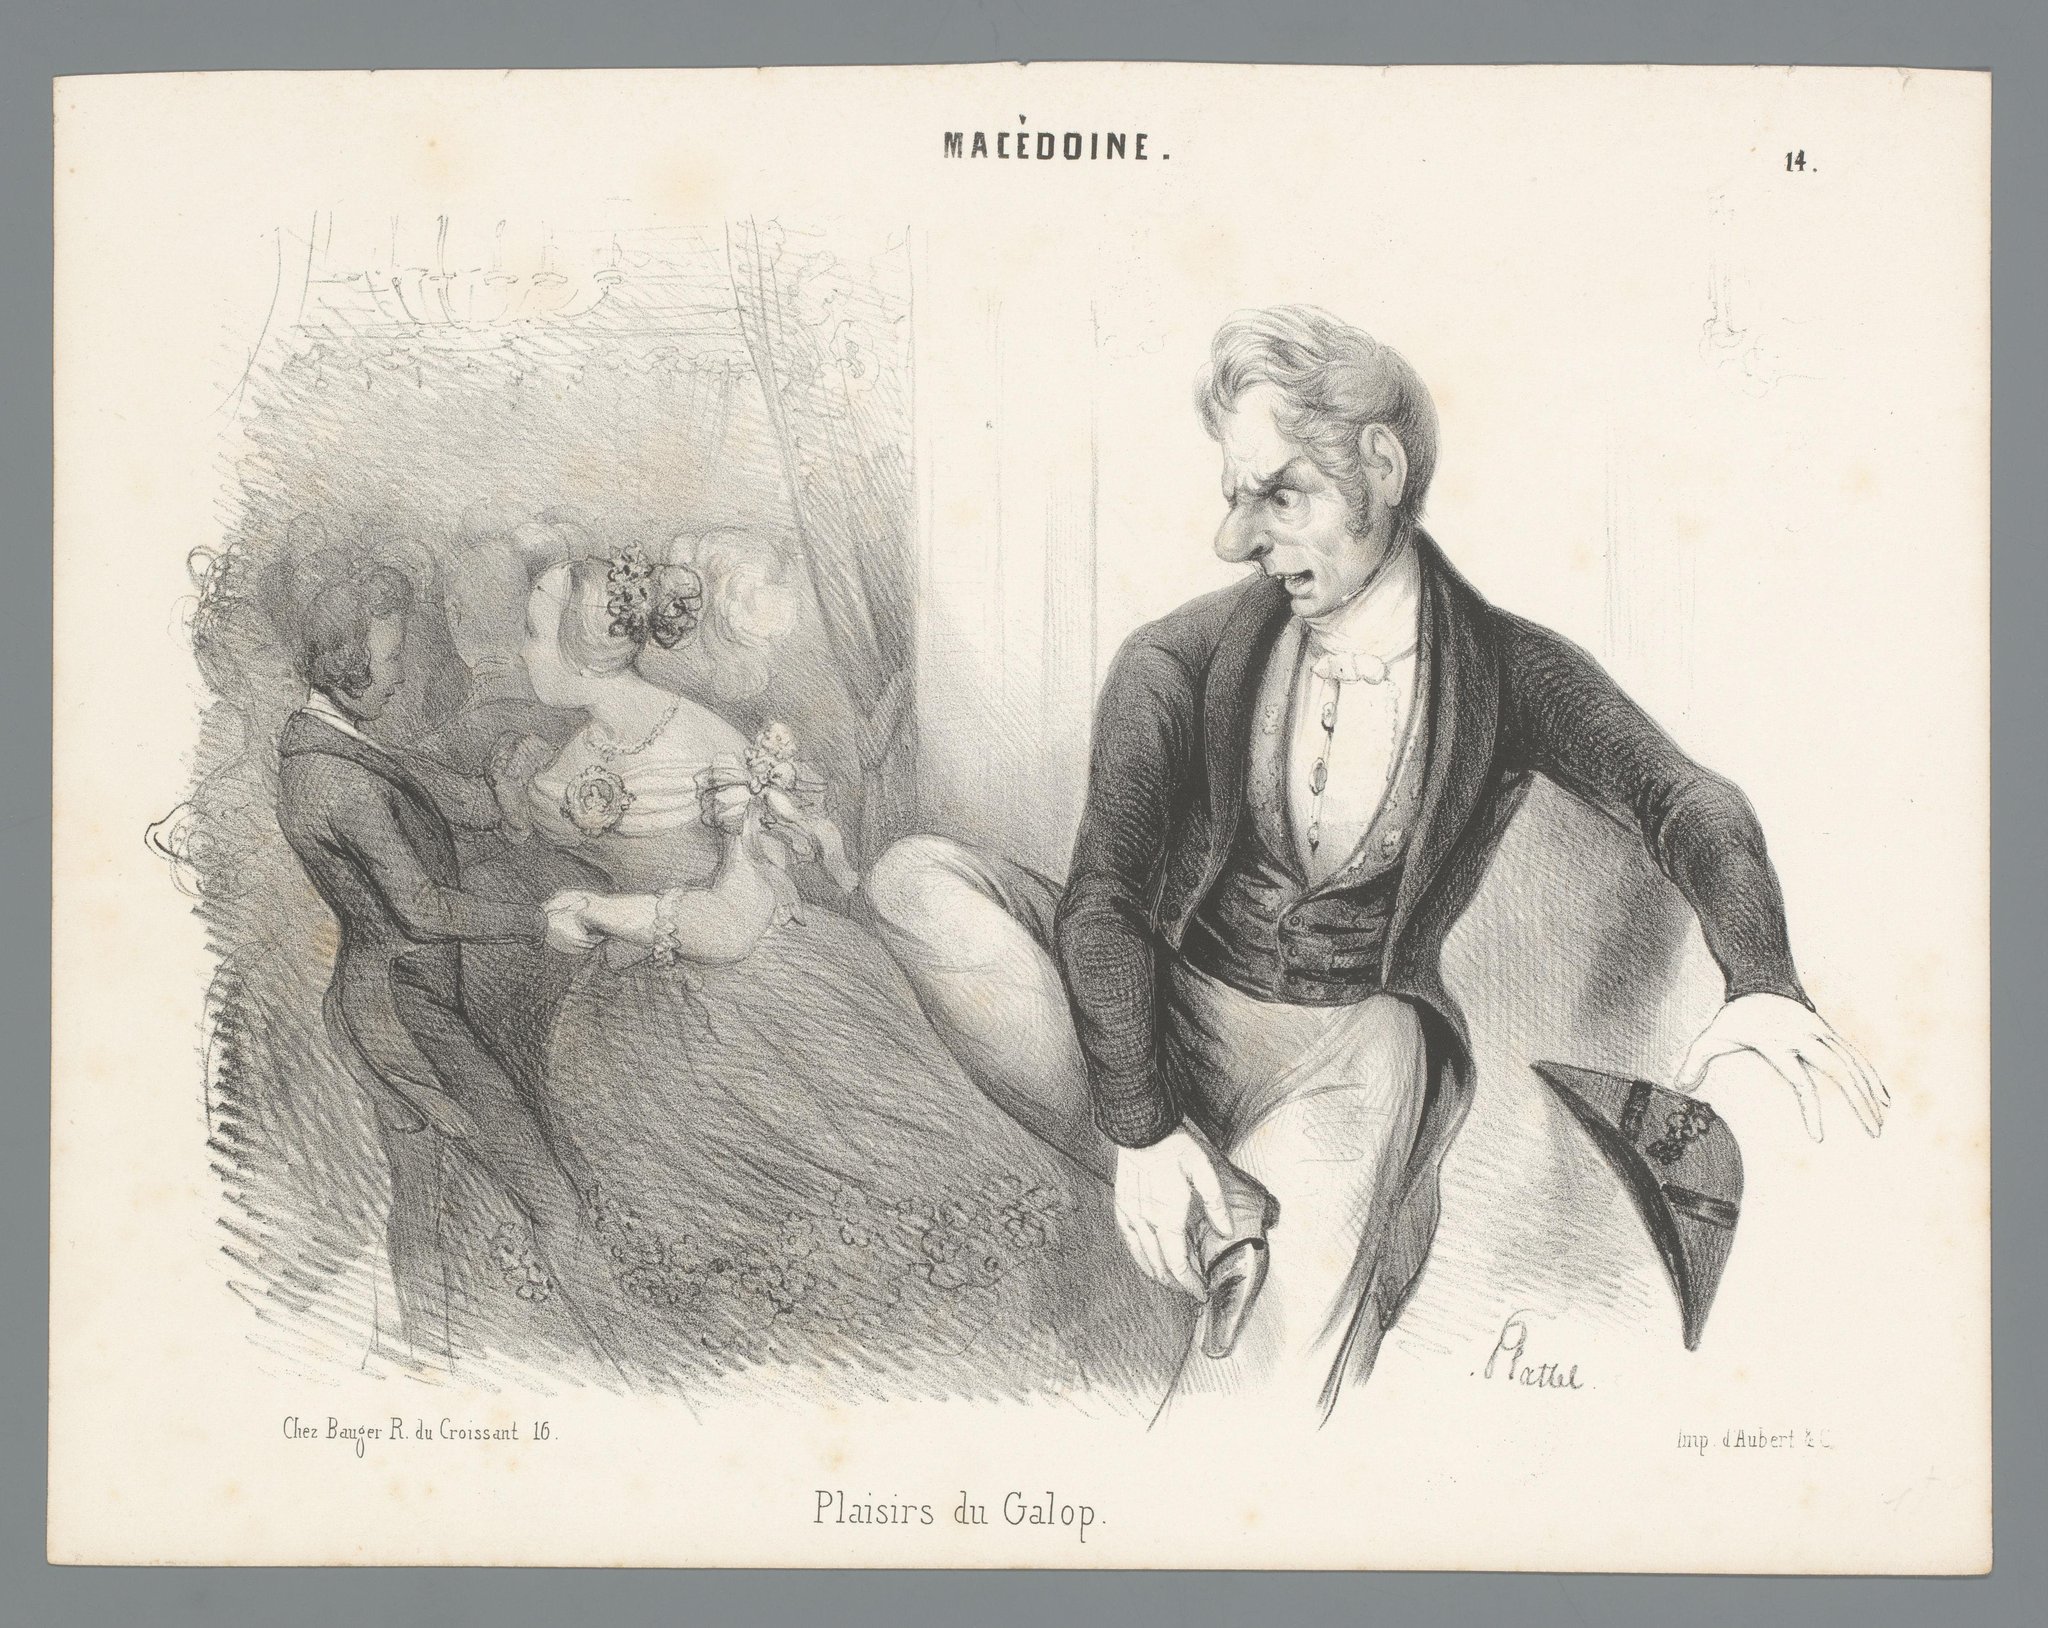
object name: print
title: Macédoine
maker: henri daniel plattel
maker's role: print maker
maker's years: 1803-1859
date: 1829-1842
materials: paper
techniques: lithograph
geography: paris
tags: ball, formal dance, adult man, pain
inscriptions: inscription: ‘Robert Pronti, 31 Juli 1964 N.F. 1.-’, stamp: ‘1062’, collector's mark: Lugt 2228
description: Prent mogelijk ook gebruikt in: Le Charivari.